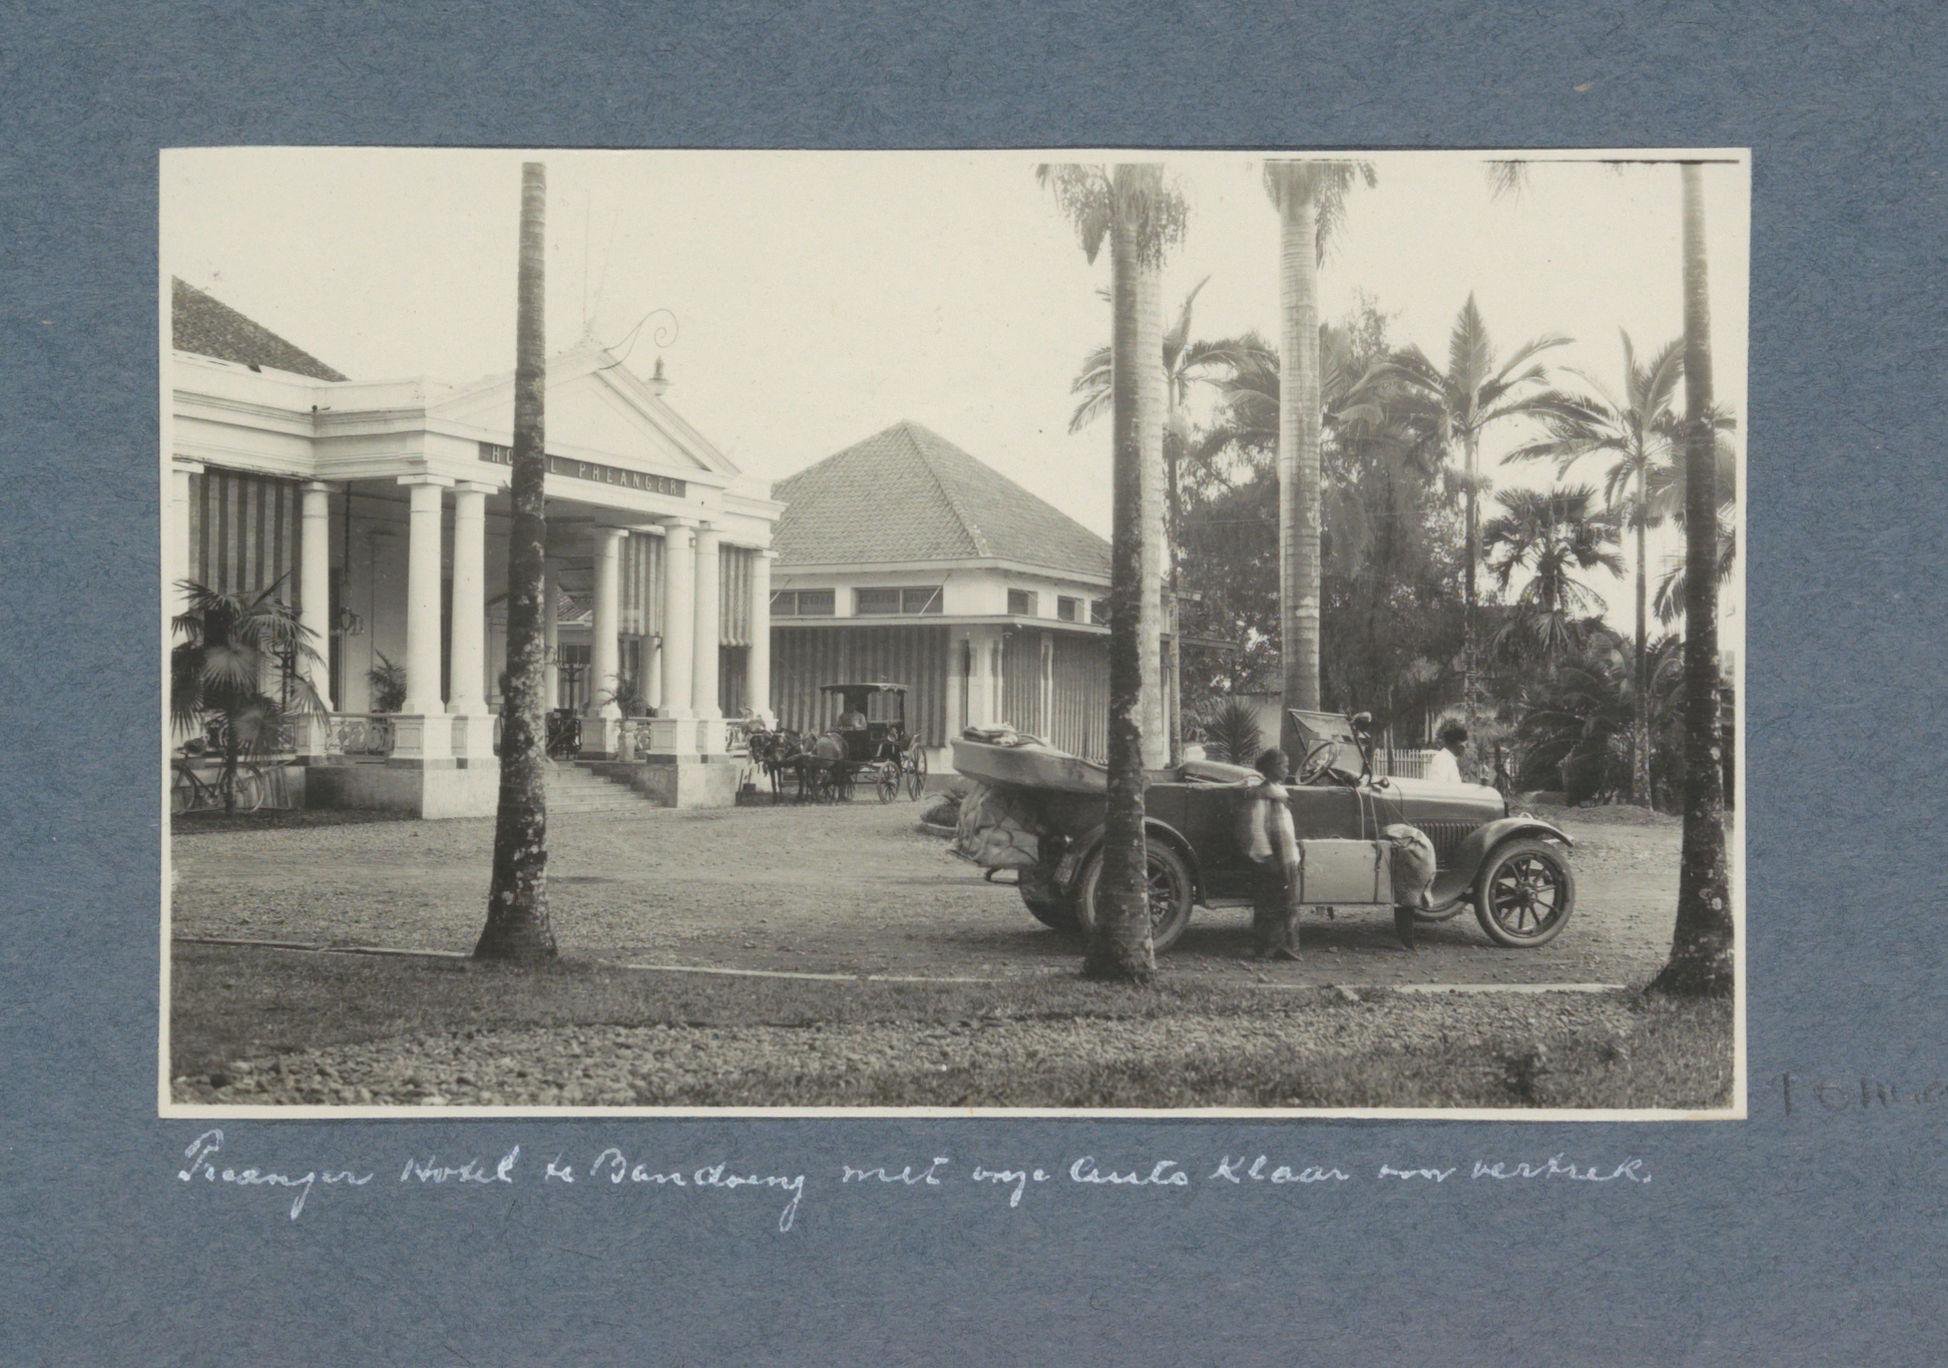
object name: photograph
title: Auto voor Hotel Preanger te Bandoeng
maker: Anonymous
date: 1900-1920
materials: paper, photographic support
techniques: gelatin silver print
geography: bandung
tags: automobile, hotel, hostelry, inn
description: Onderdeel van reisalbum met foto's van bedrijvigheid en bezienswaardigheden op Sumatra en Java en van de reis naar en van Nederlands-Indië.